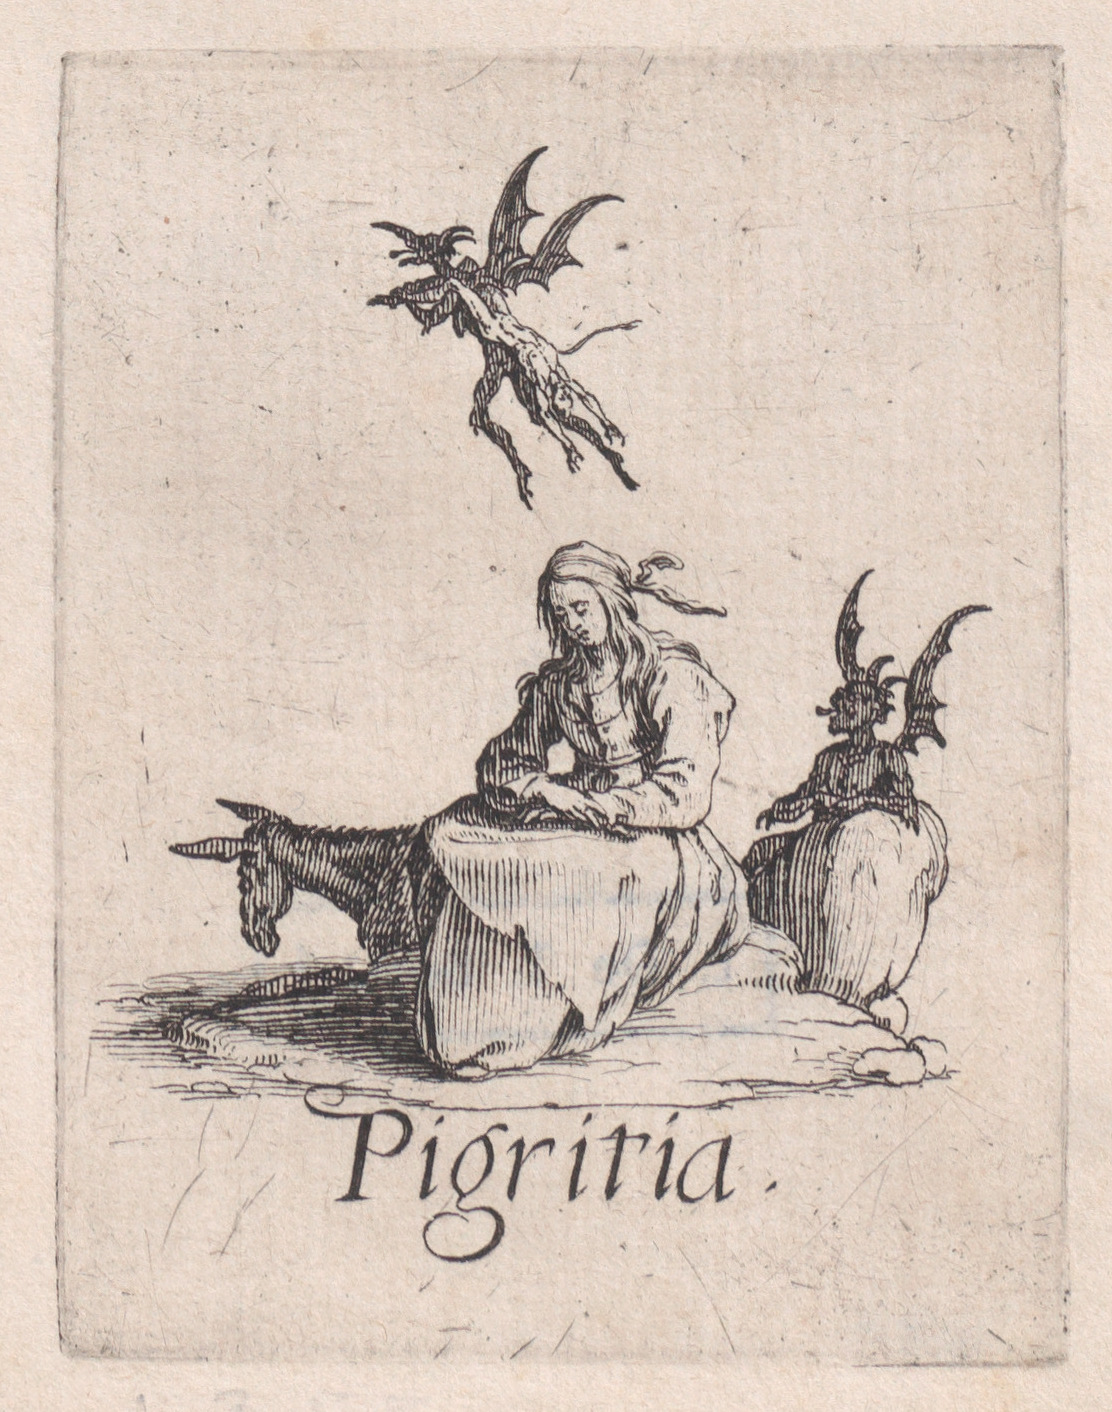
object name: print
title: La Paresse (Sloth), from "Les Péchées Capitaux" (The Deadly Sins)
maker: jacques callot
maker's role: artist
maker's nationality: french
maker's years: 1592-1635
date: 1620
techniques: engraving, etching